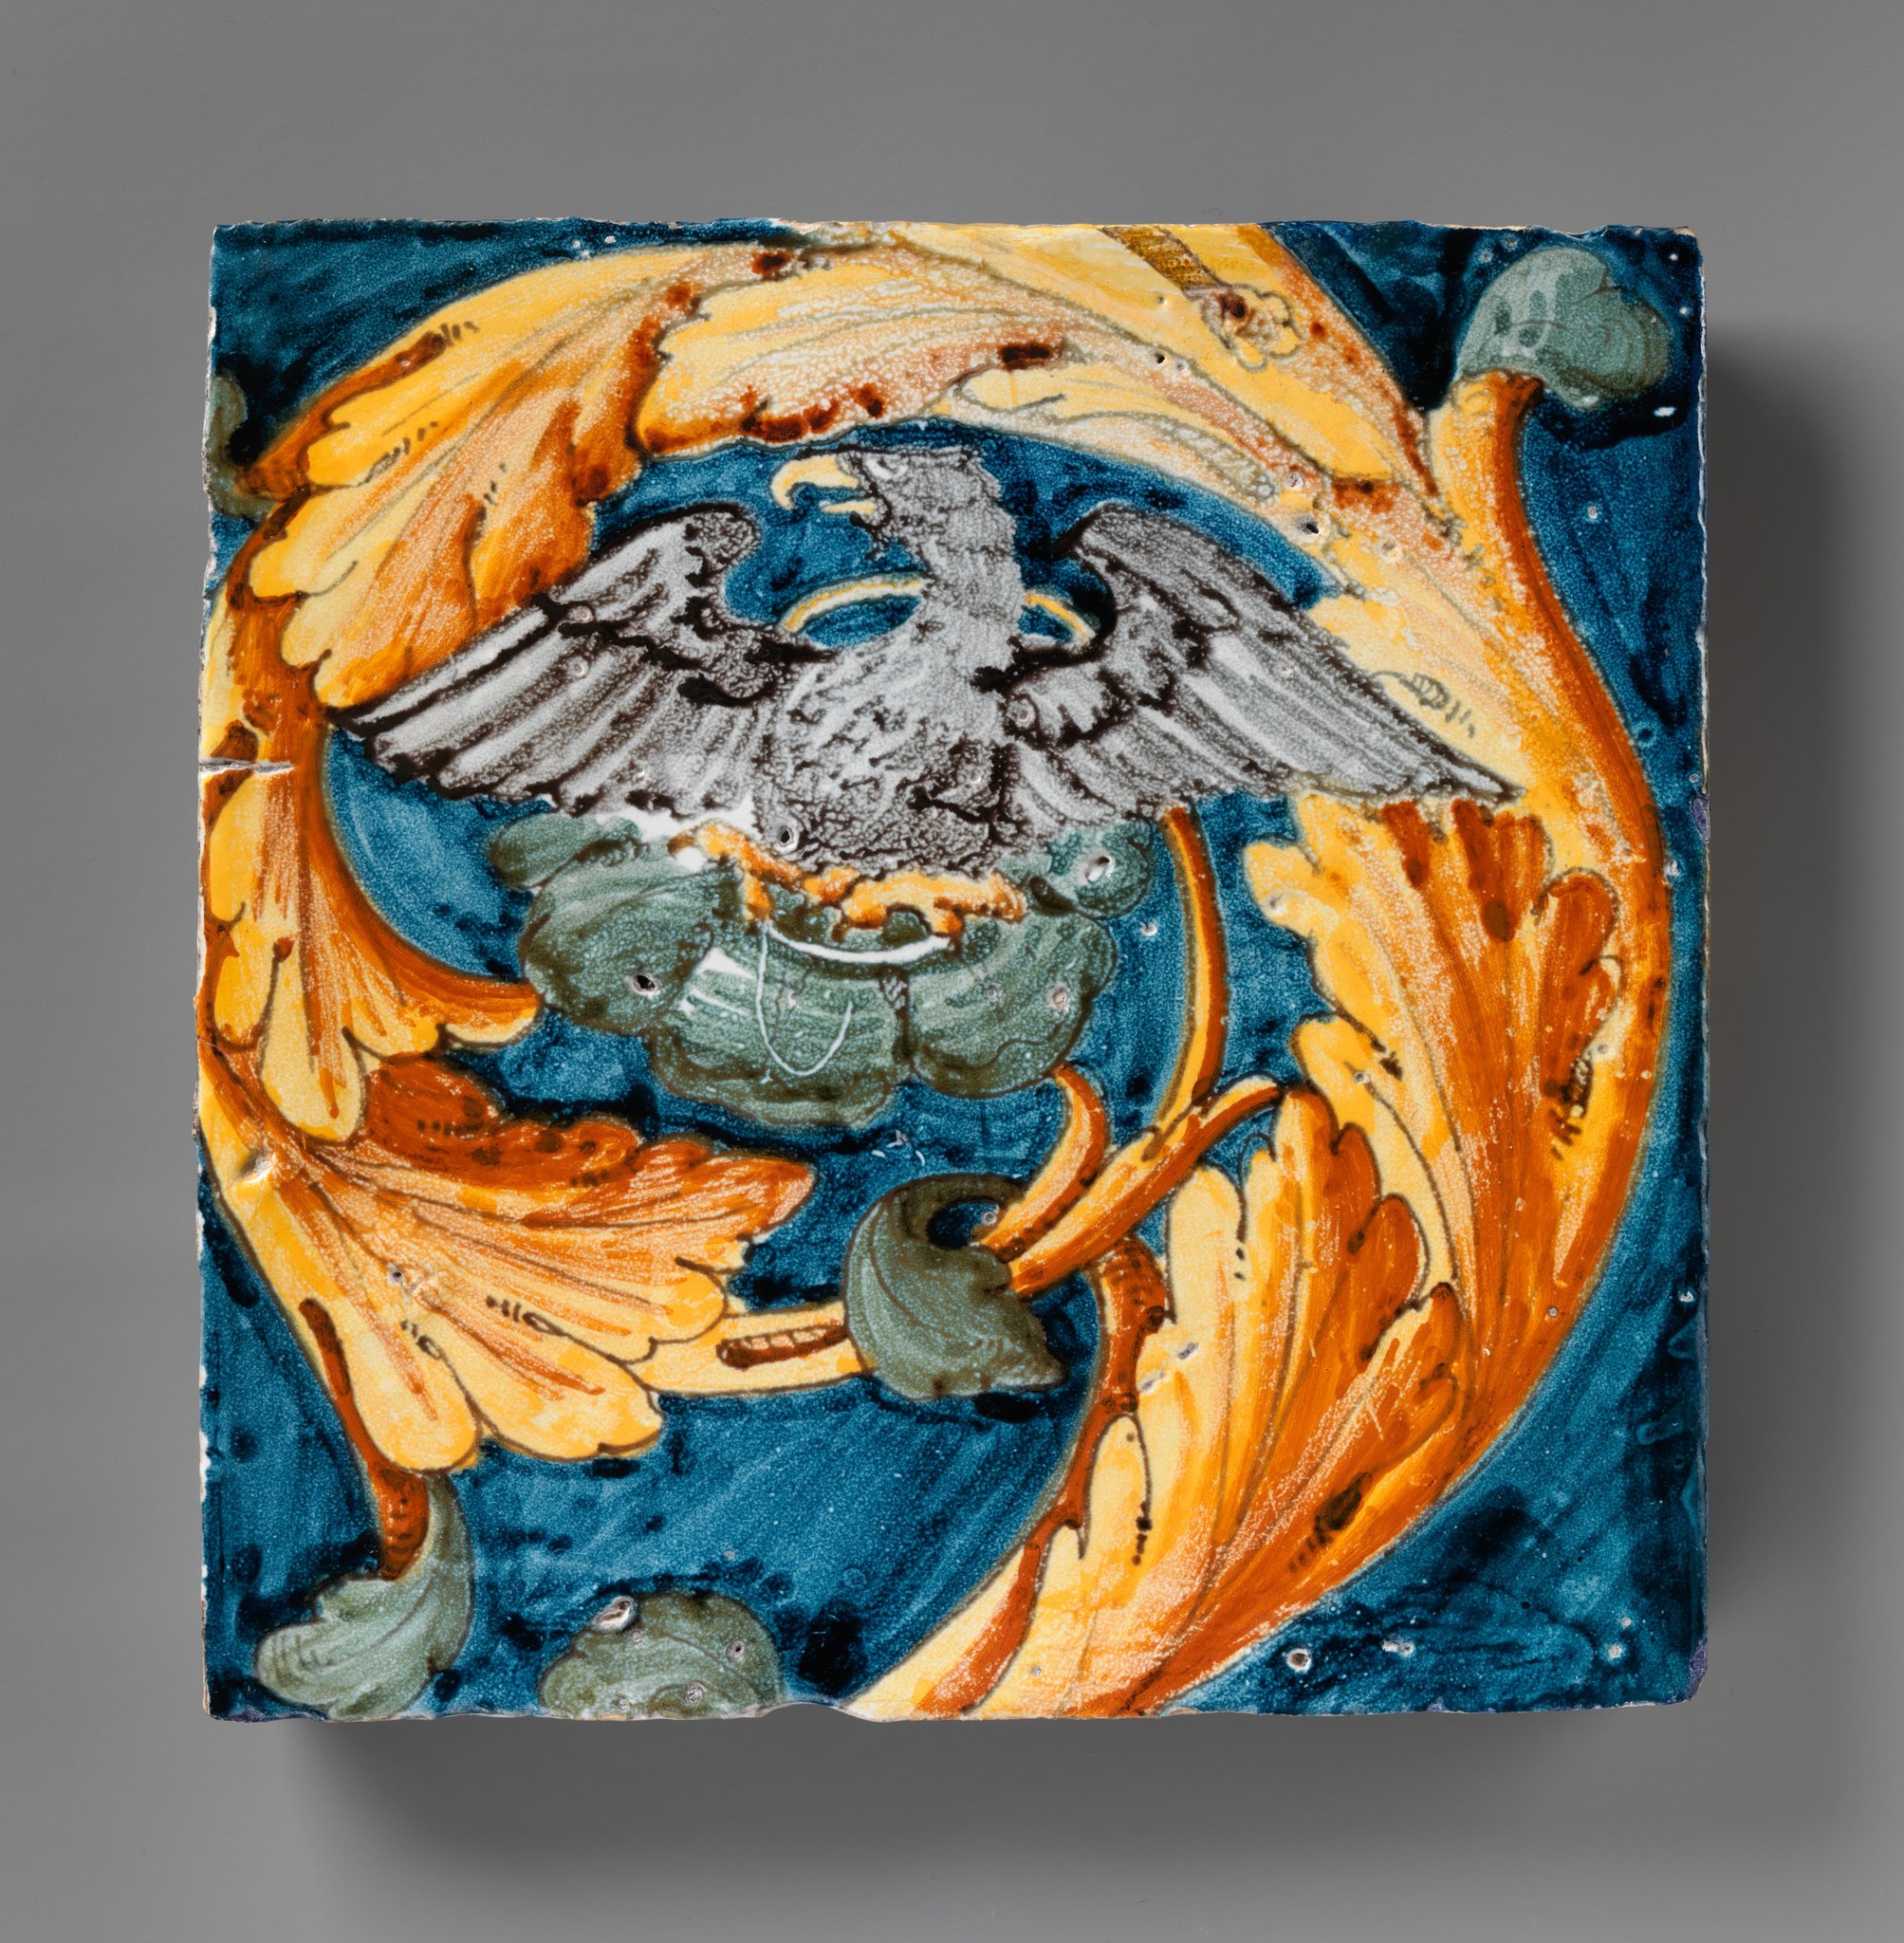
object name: tile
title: Tile with corner edge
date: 1617-1627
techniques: maiolica, glazing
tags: eagles